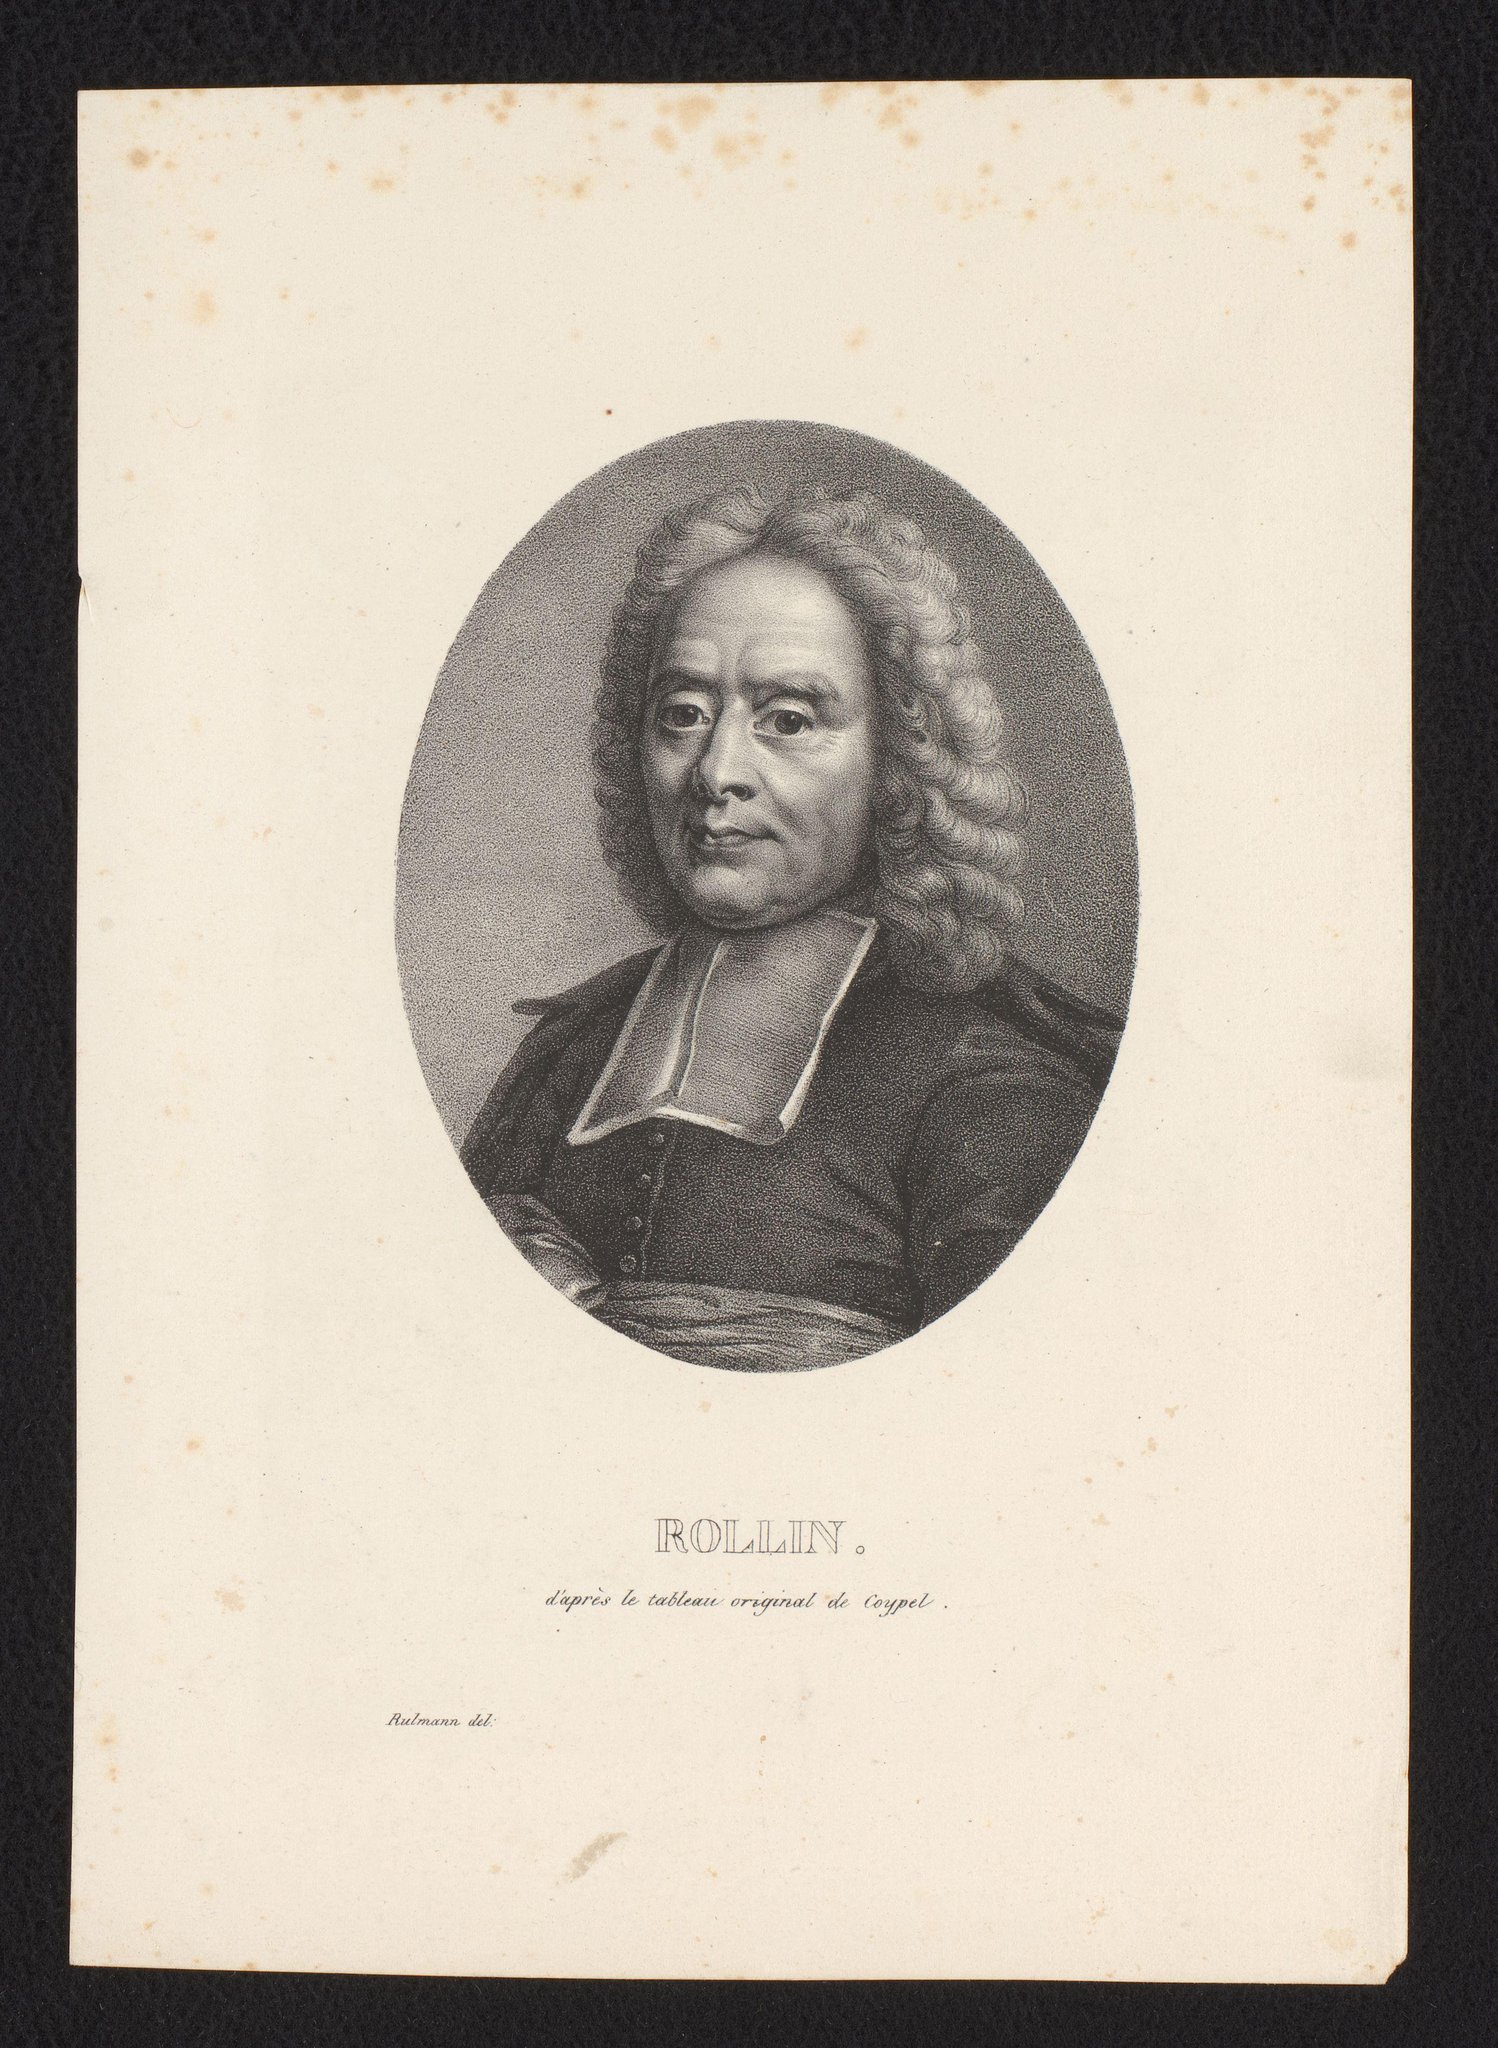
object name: print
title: Portret van theoloog Charles Rollin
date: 1799-1822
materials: paper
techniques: lithograph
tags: paris, charles rollin, historical persons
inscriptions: collector's mark: Lugt 2228